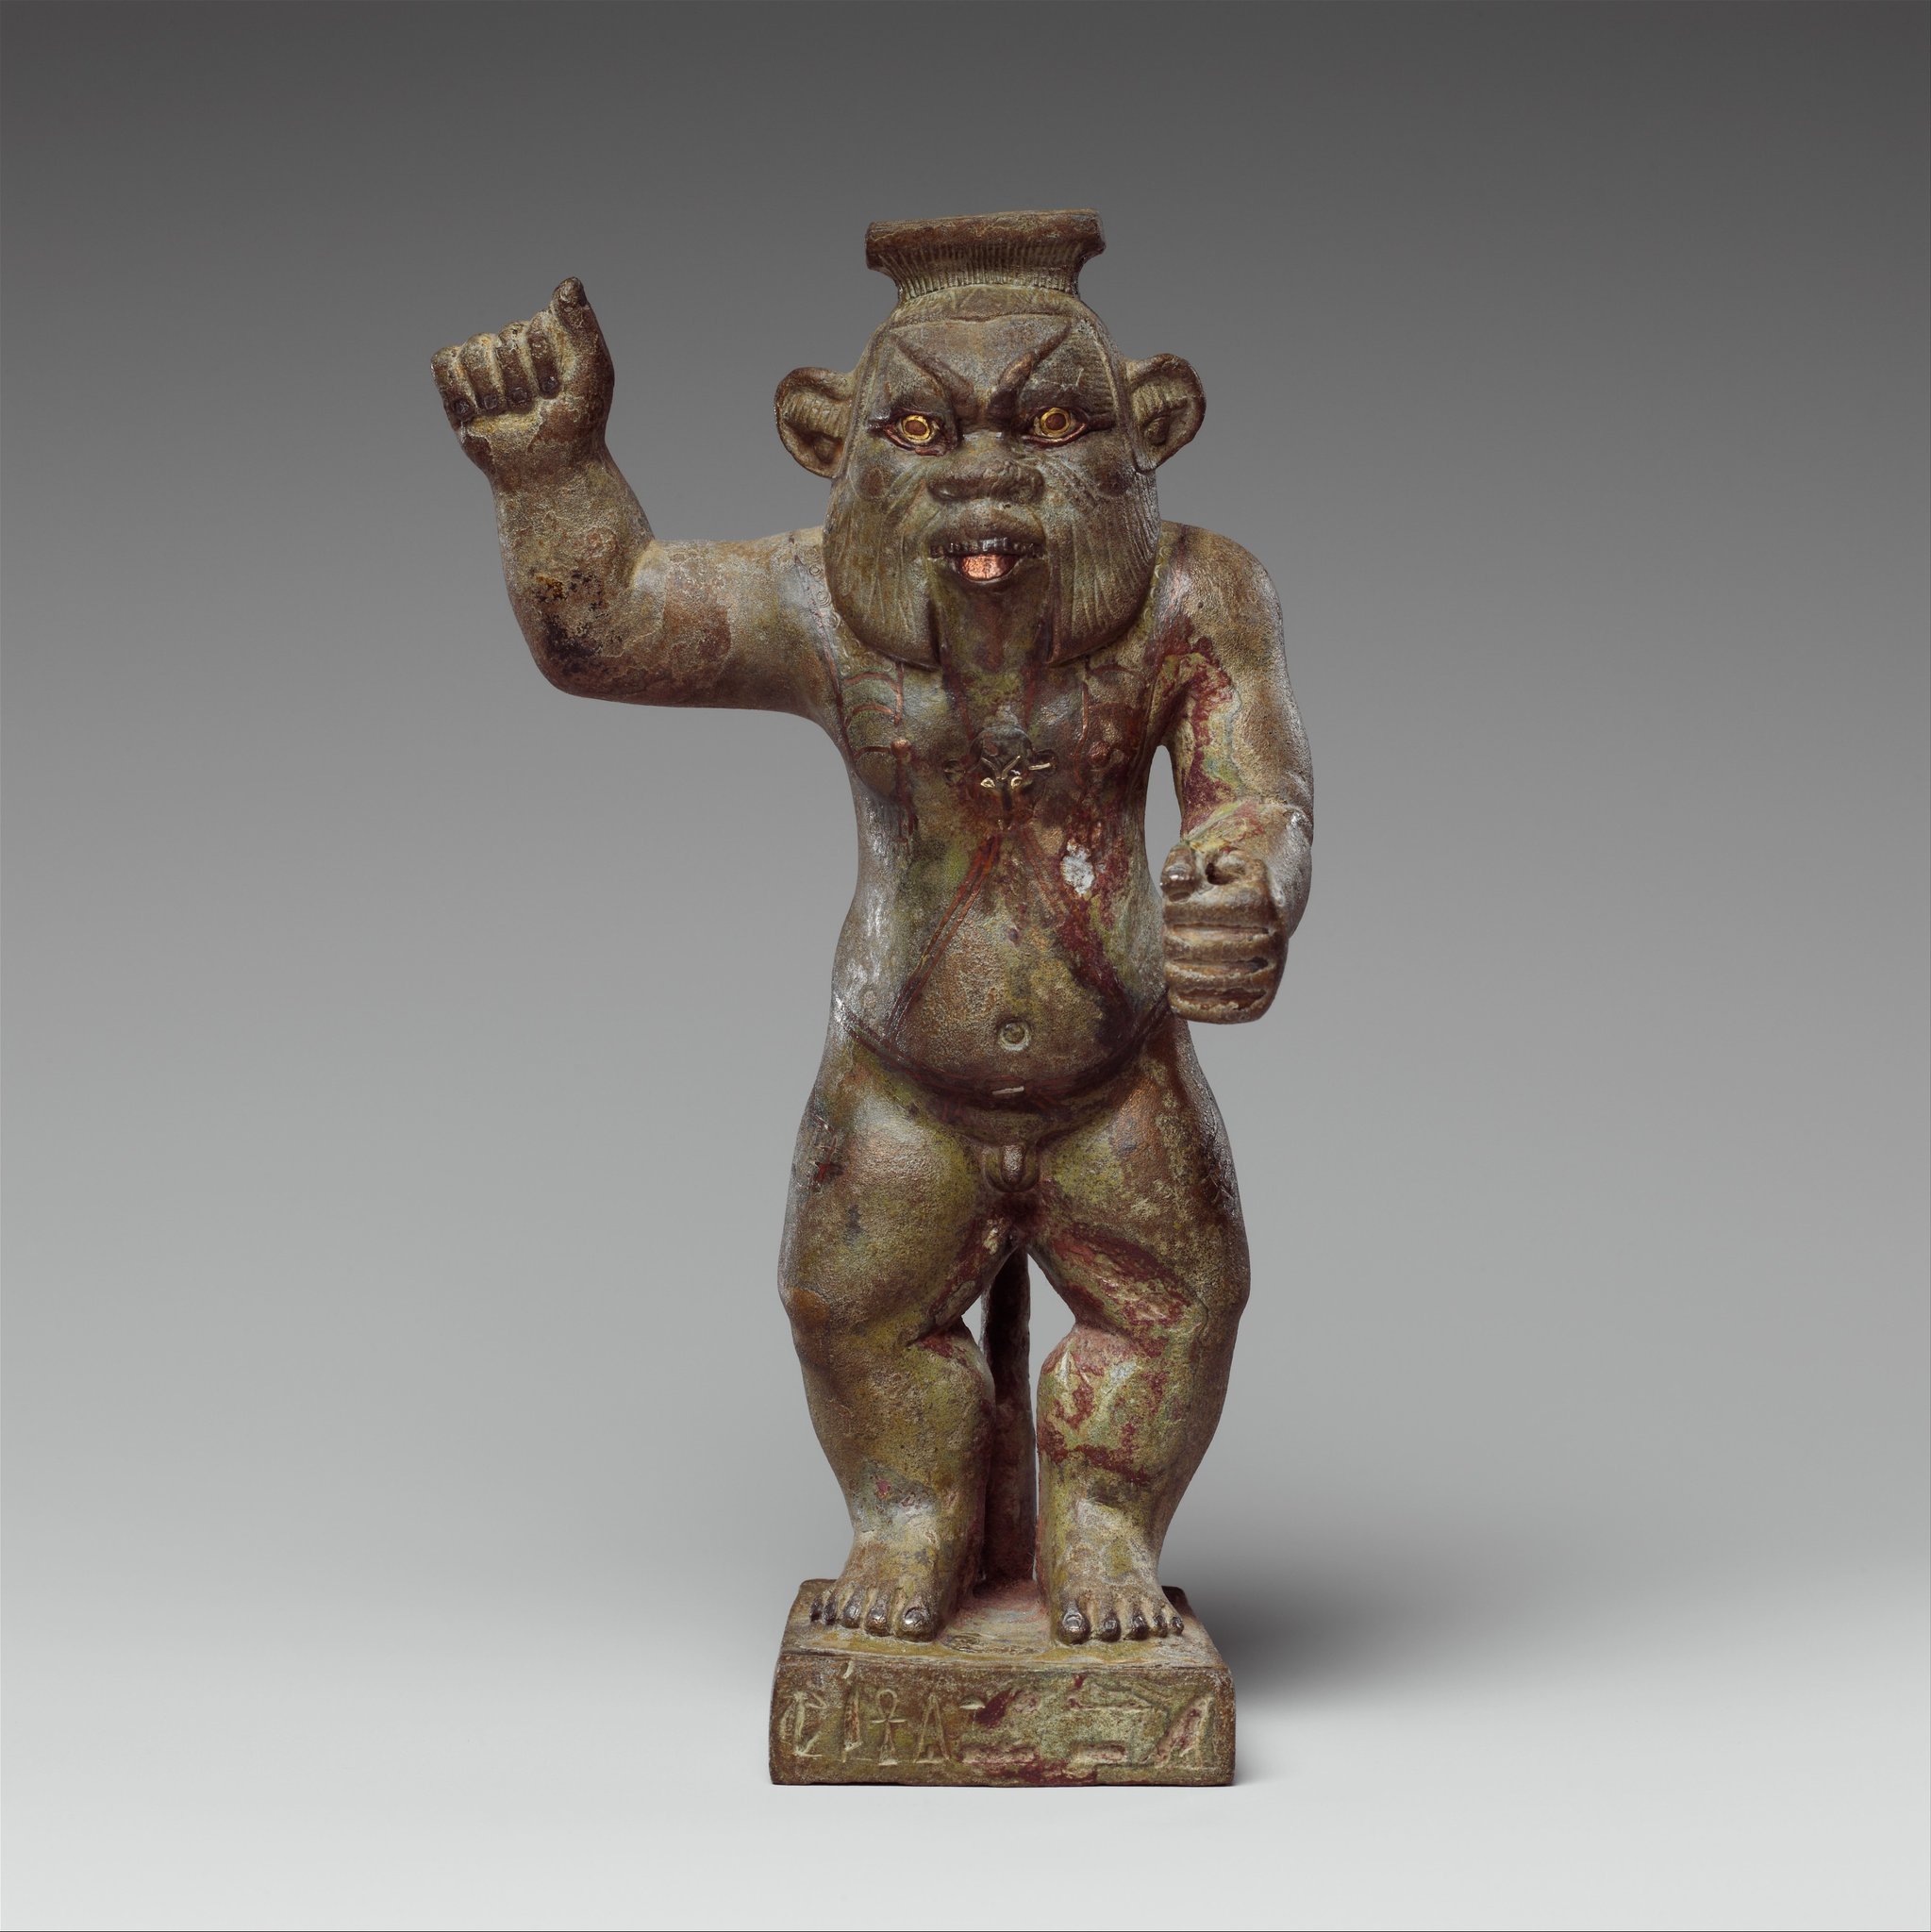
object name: statuette, be image, hor asha khet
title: Bes-image of the god Hor-Asha-Khet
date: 400-101 BCE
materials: bronze, copper, copper alloy, gold, silver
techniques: inlay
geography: egypt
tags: bes,gods